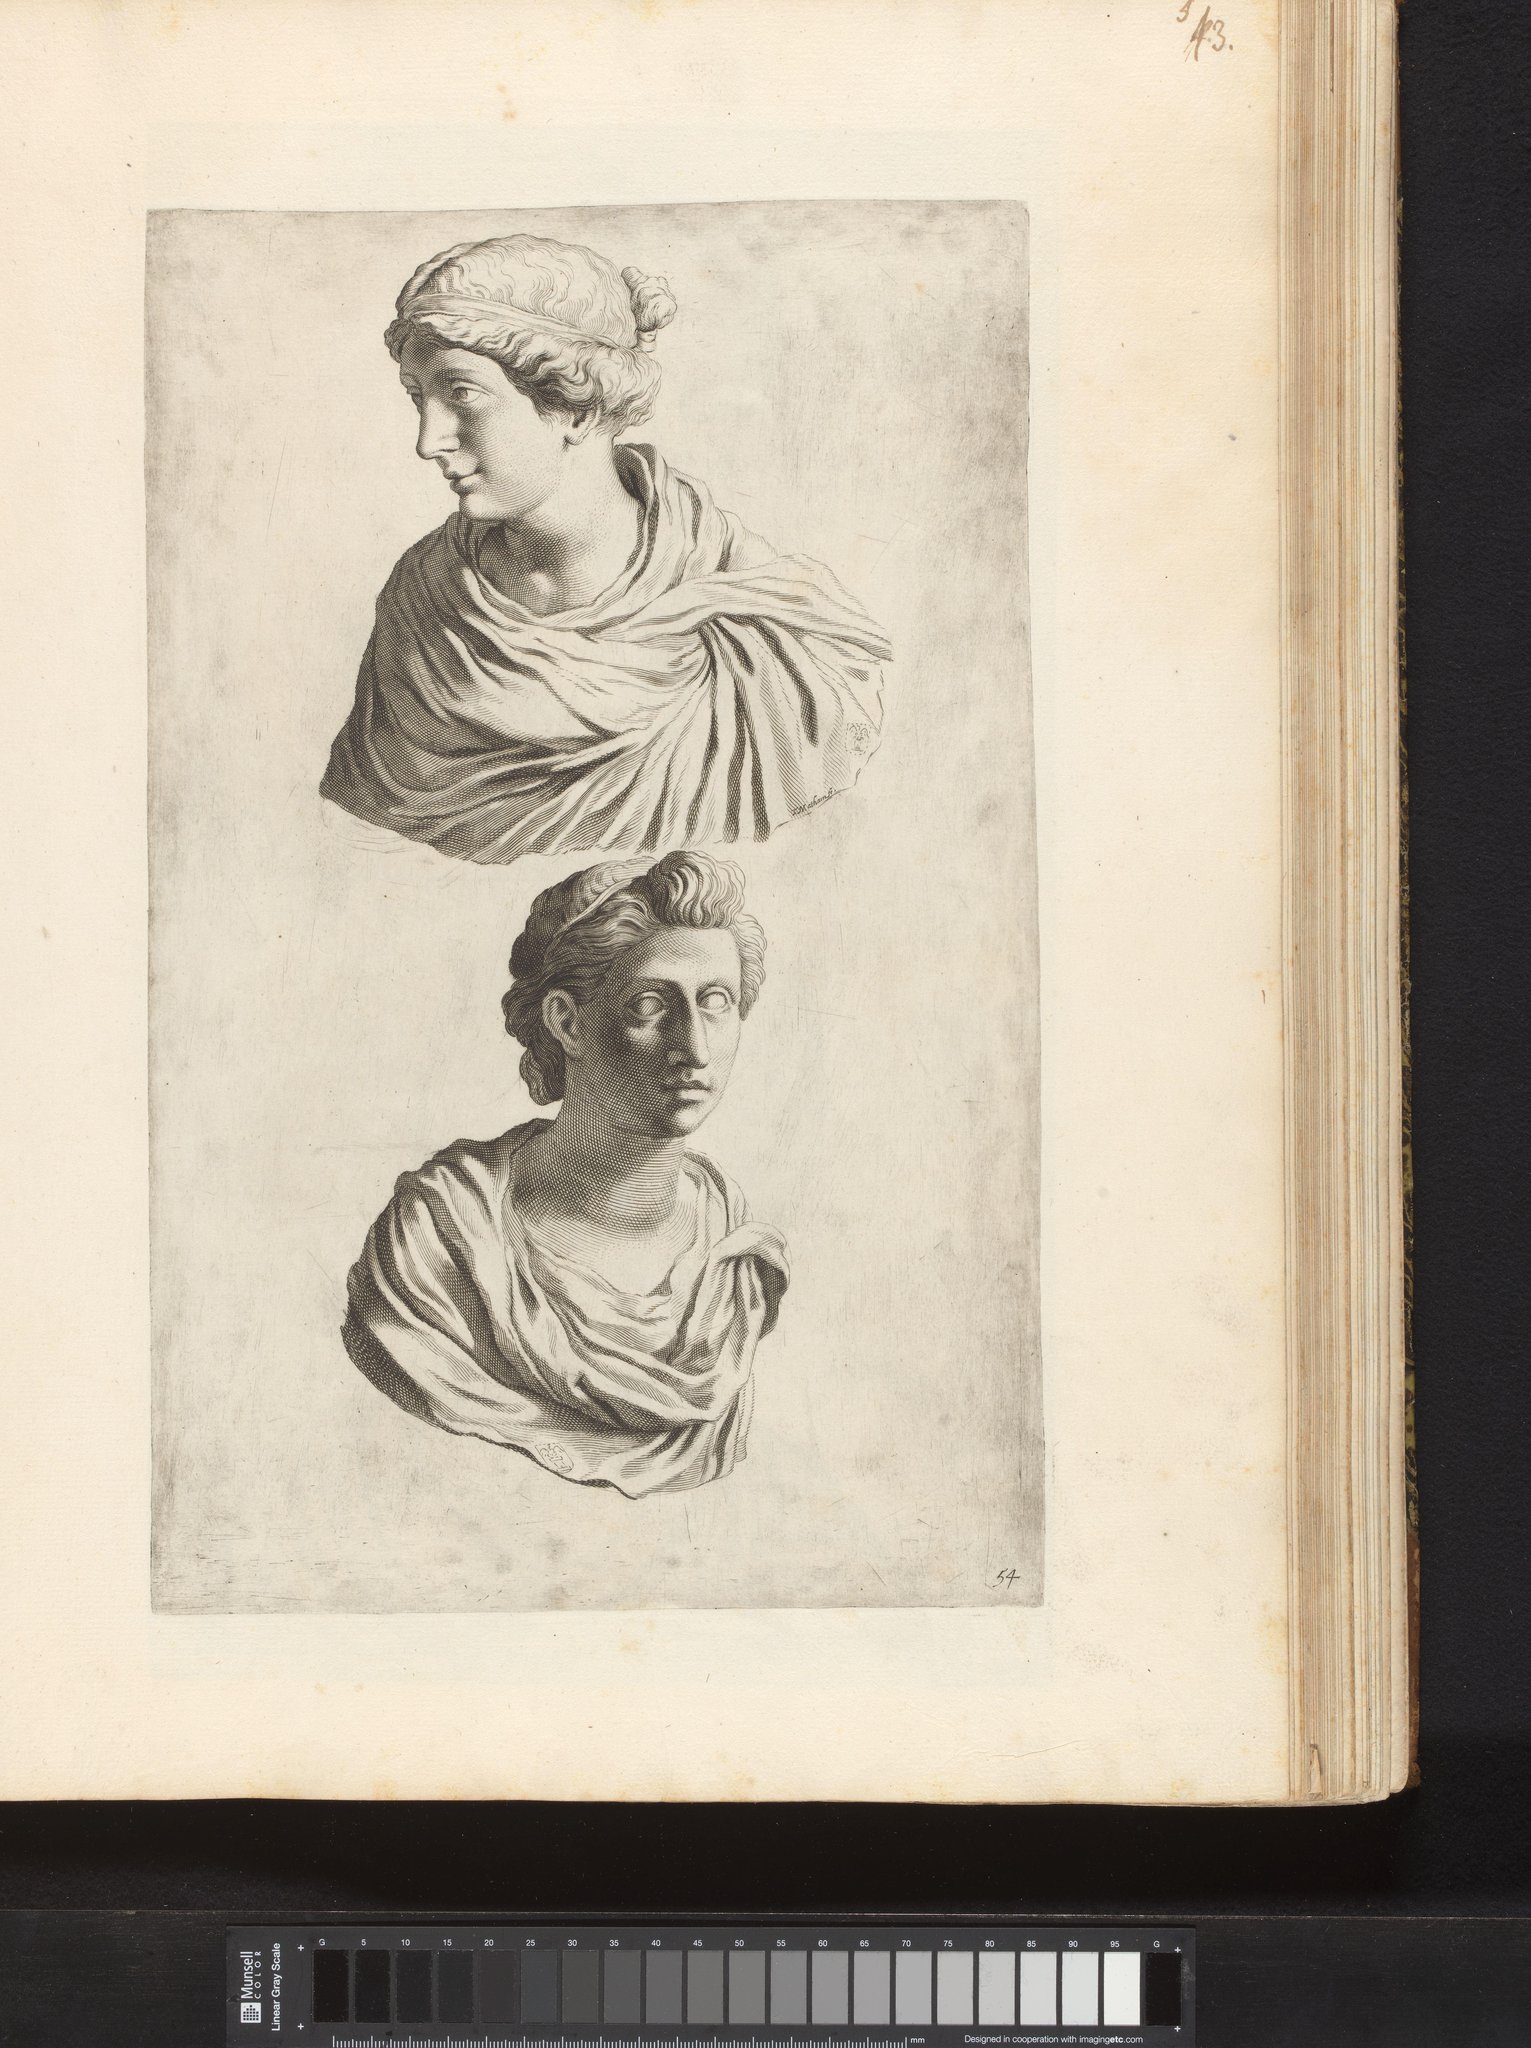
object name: album leaf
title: Twee portretbustes van Romeinse vrouwen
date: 1636-1647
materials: paper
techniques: engraving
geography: rome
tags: piece of sculpture, reproduction of a piece of sculpture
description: Twee portretbustes van Romeinse vrouwen, wellicht Faustina en Crispina. Op beide bustes het wapenschild van Vincenzo Giustiniani. Prent maakt deel uit van een album met een serie prenten naar de sculpturen in de verzameling in de Galleria Giustiniani te Rome.